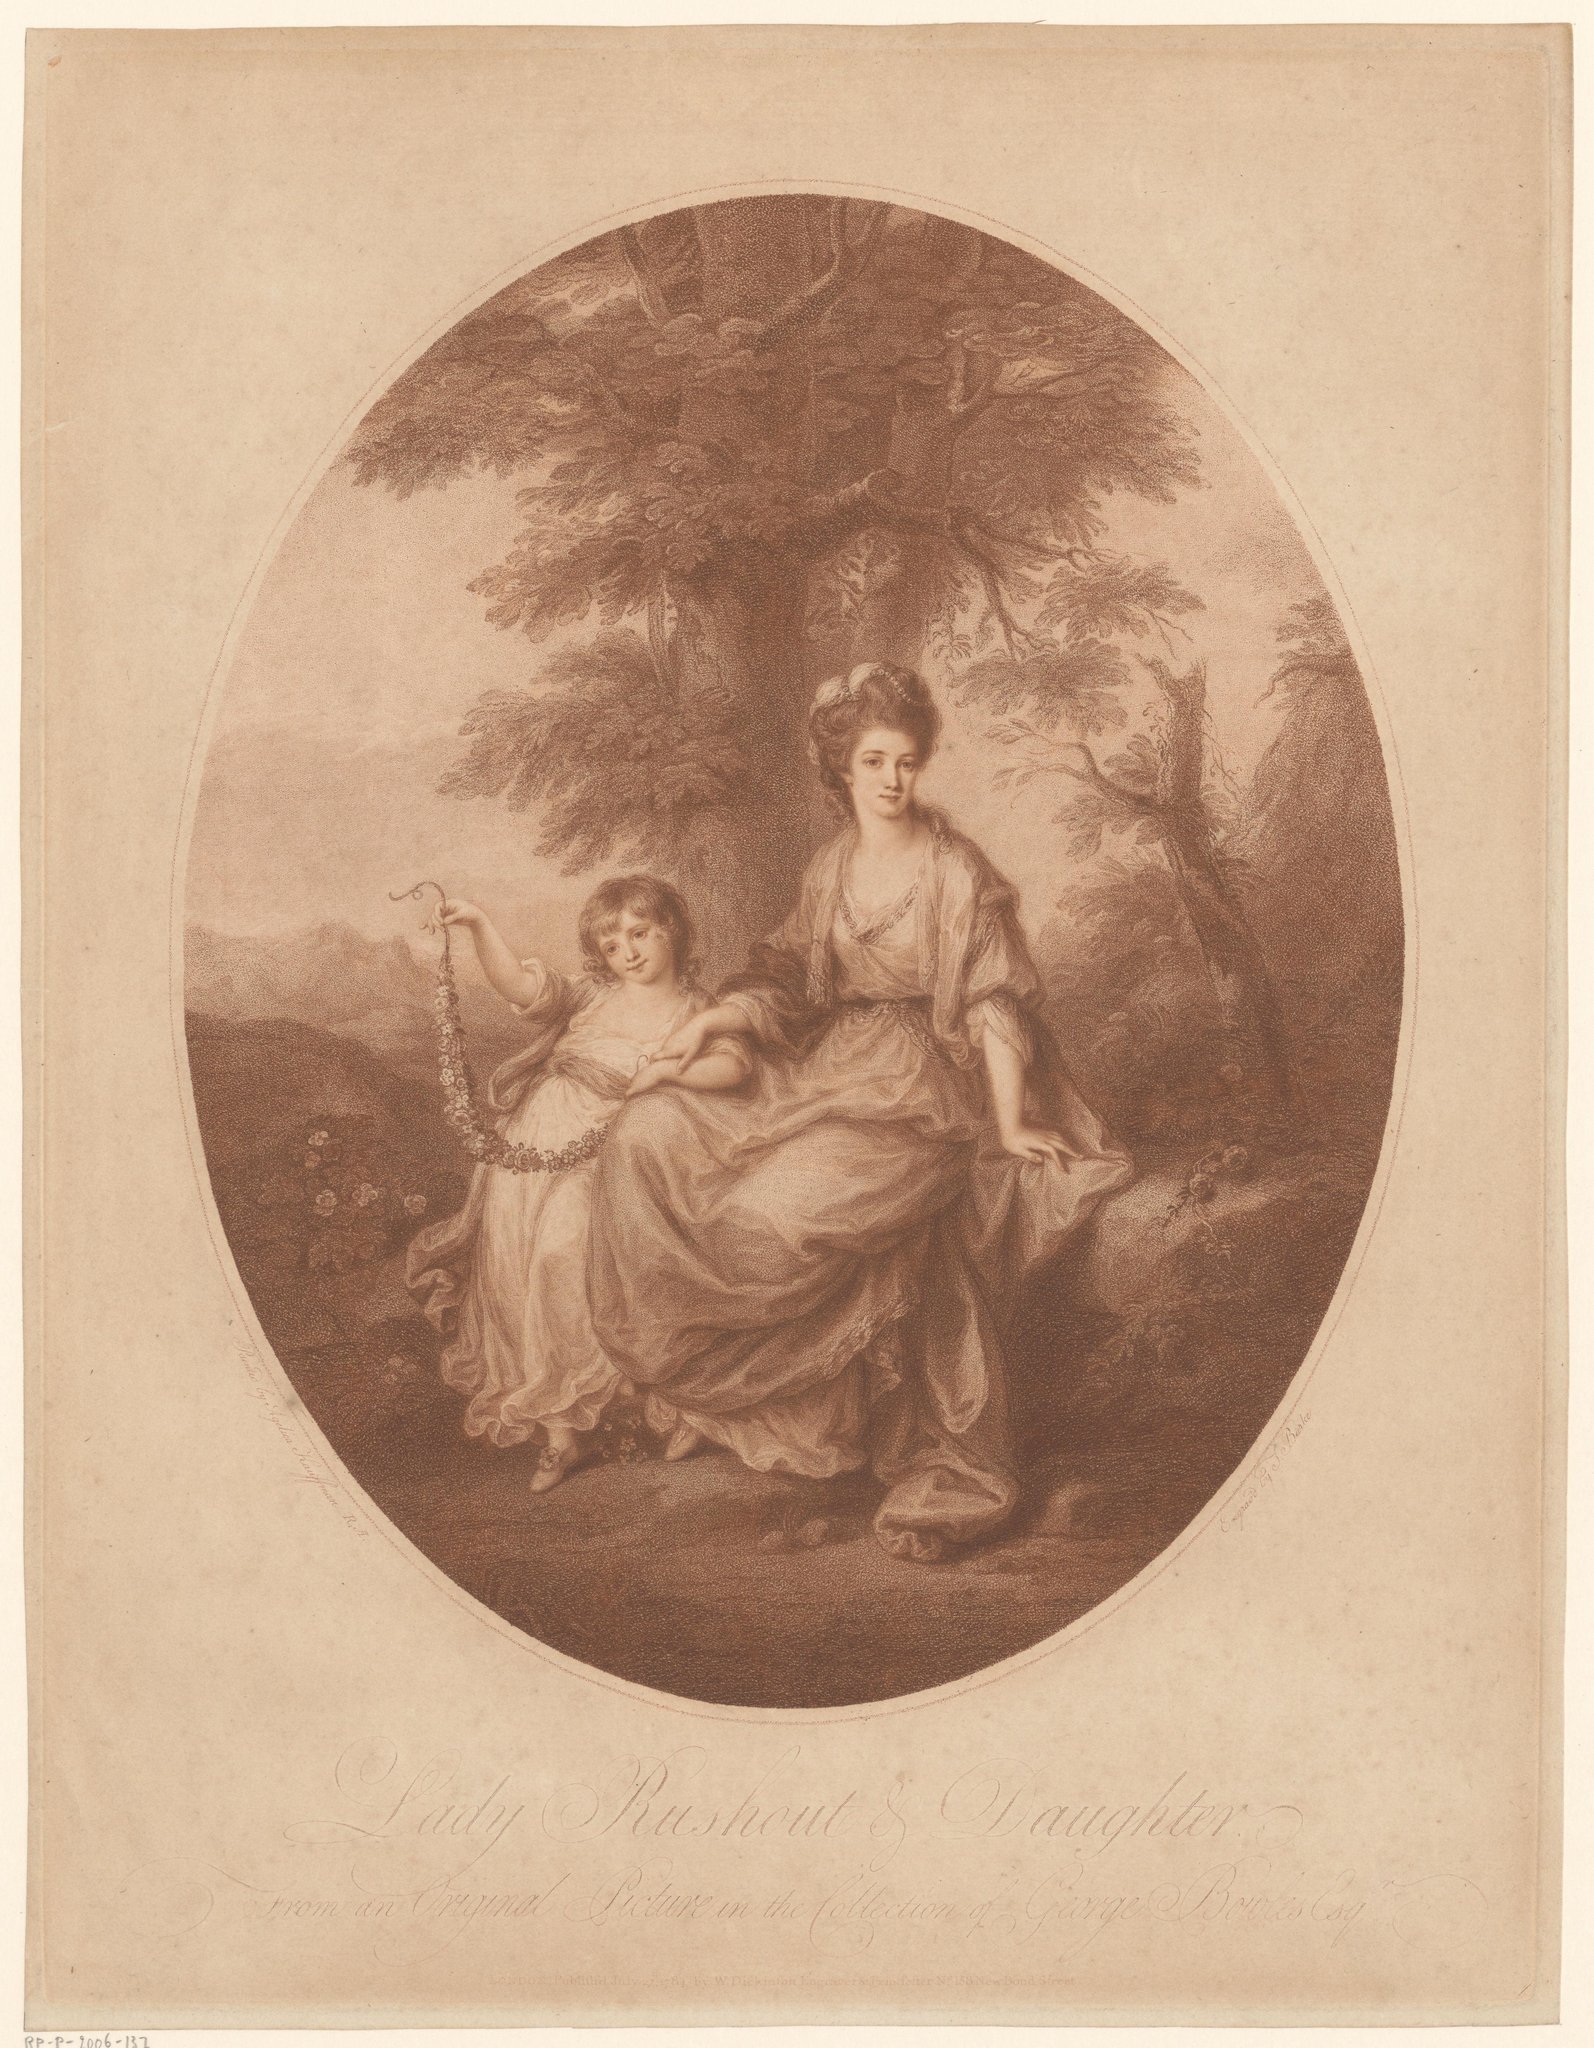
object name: print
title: Lady Rushout & Daughter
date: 1784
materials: paper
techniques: printmaking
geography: london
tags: garland, wreath, historical persons - bb - woman, mother and daughter(s) (family group)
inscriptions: collector's mark: Lugt 2228, collector's mark: Lugt 2760